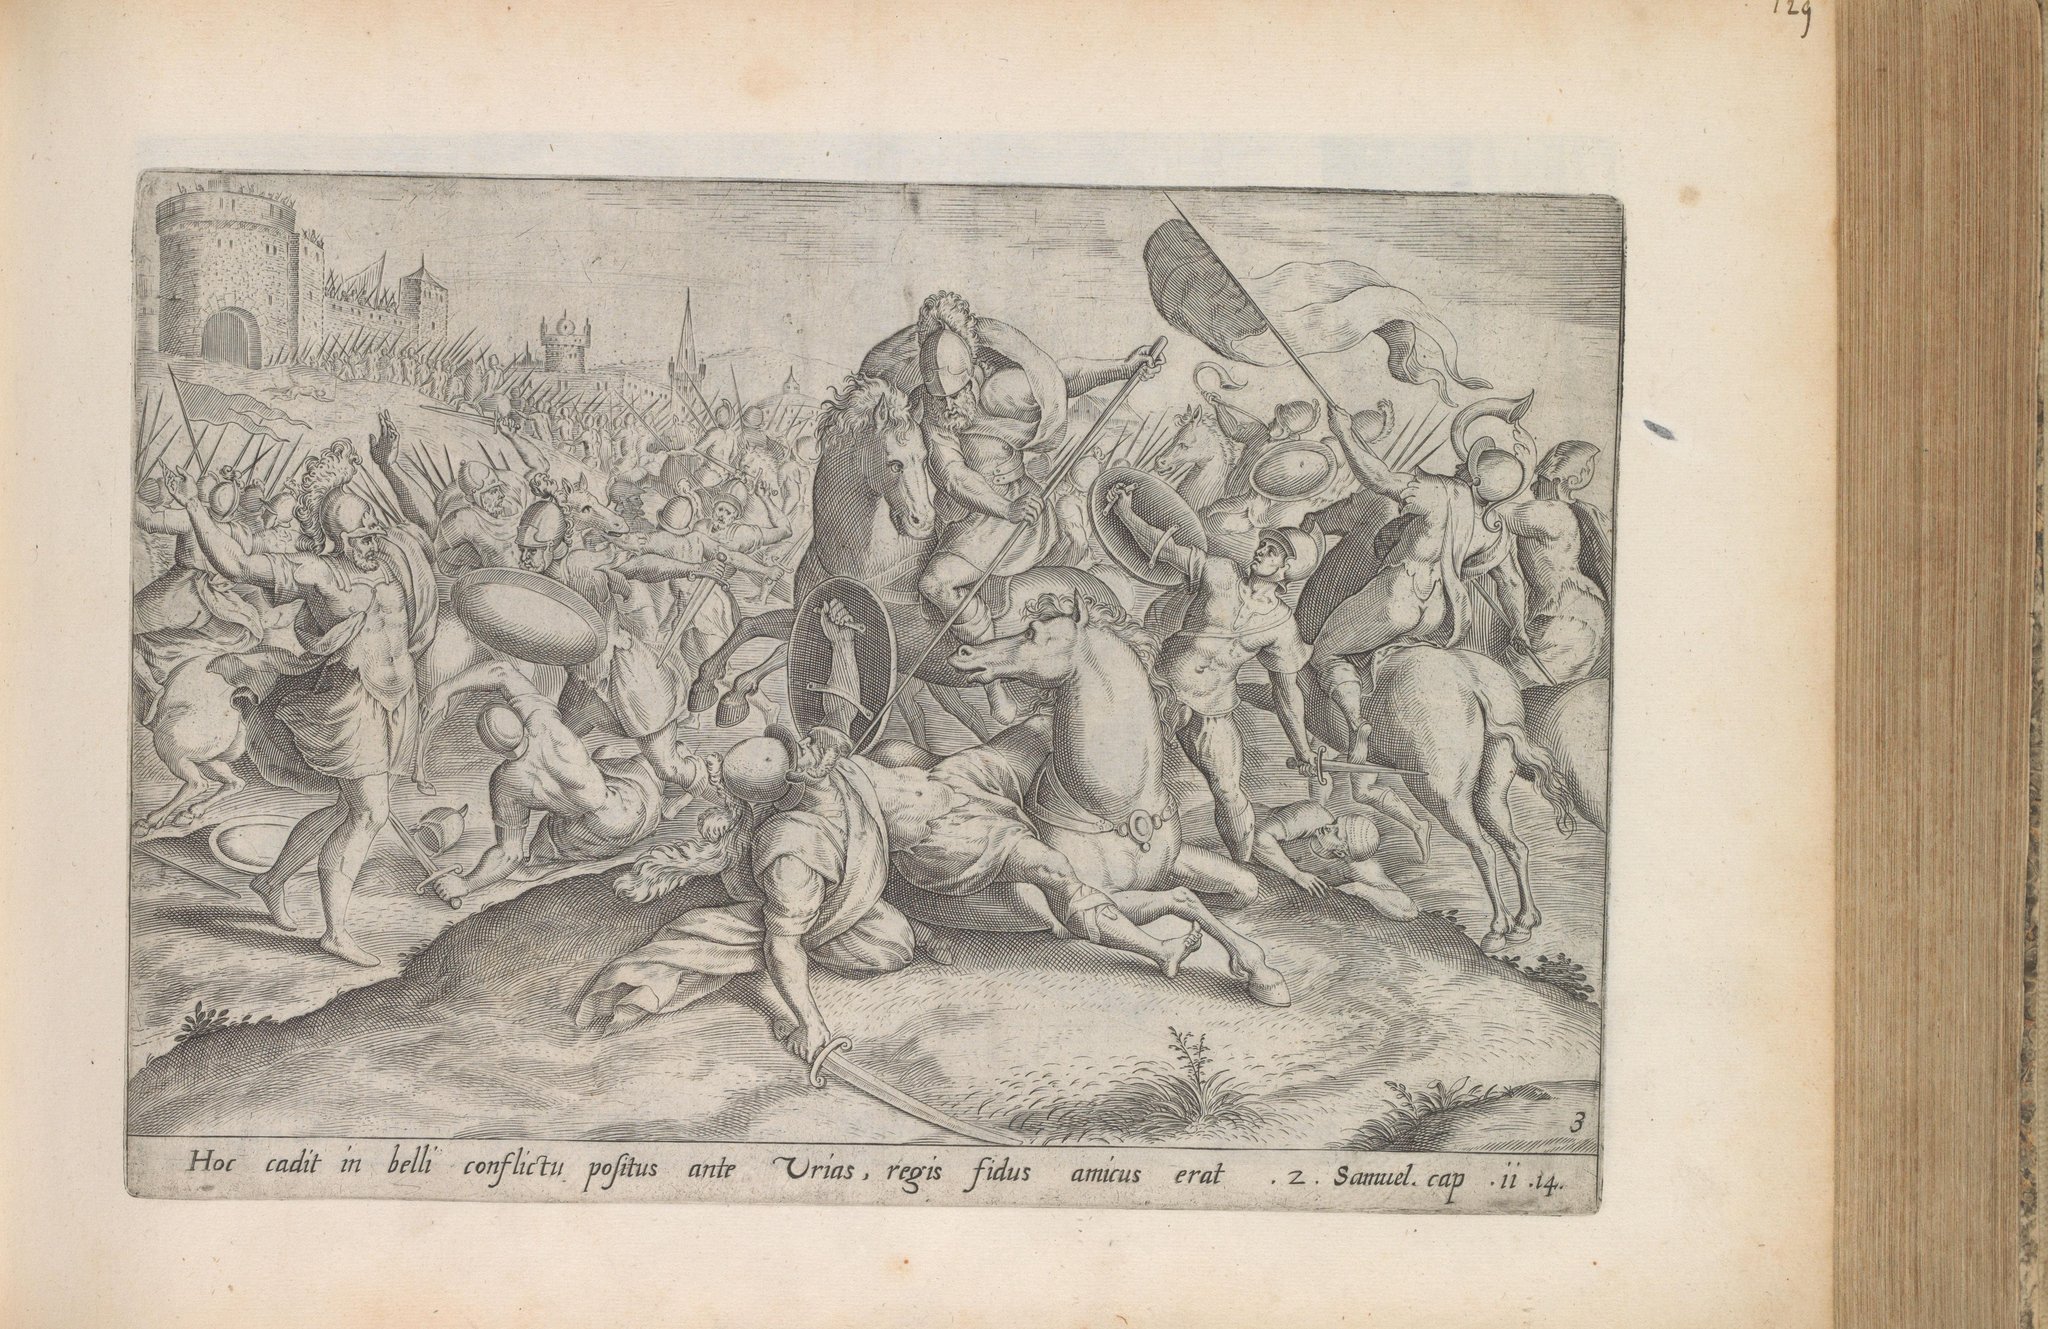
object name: album leaf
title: Dood van Uria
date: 1579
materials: paper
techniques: engraving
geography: amsterdam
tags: uriah is killed in the battle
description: Uria is in opdracht van koning David vooraan op de gevaarlijkste plek in de strijd geplaatst. Hij wordt door de vijand gedood met een lans. Onder de voorstelling een verwijzing in het Latijn naar de Bijbeltekst in 2 Sam. 11:14. Deze prent maakt deel uit van een album.